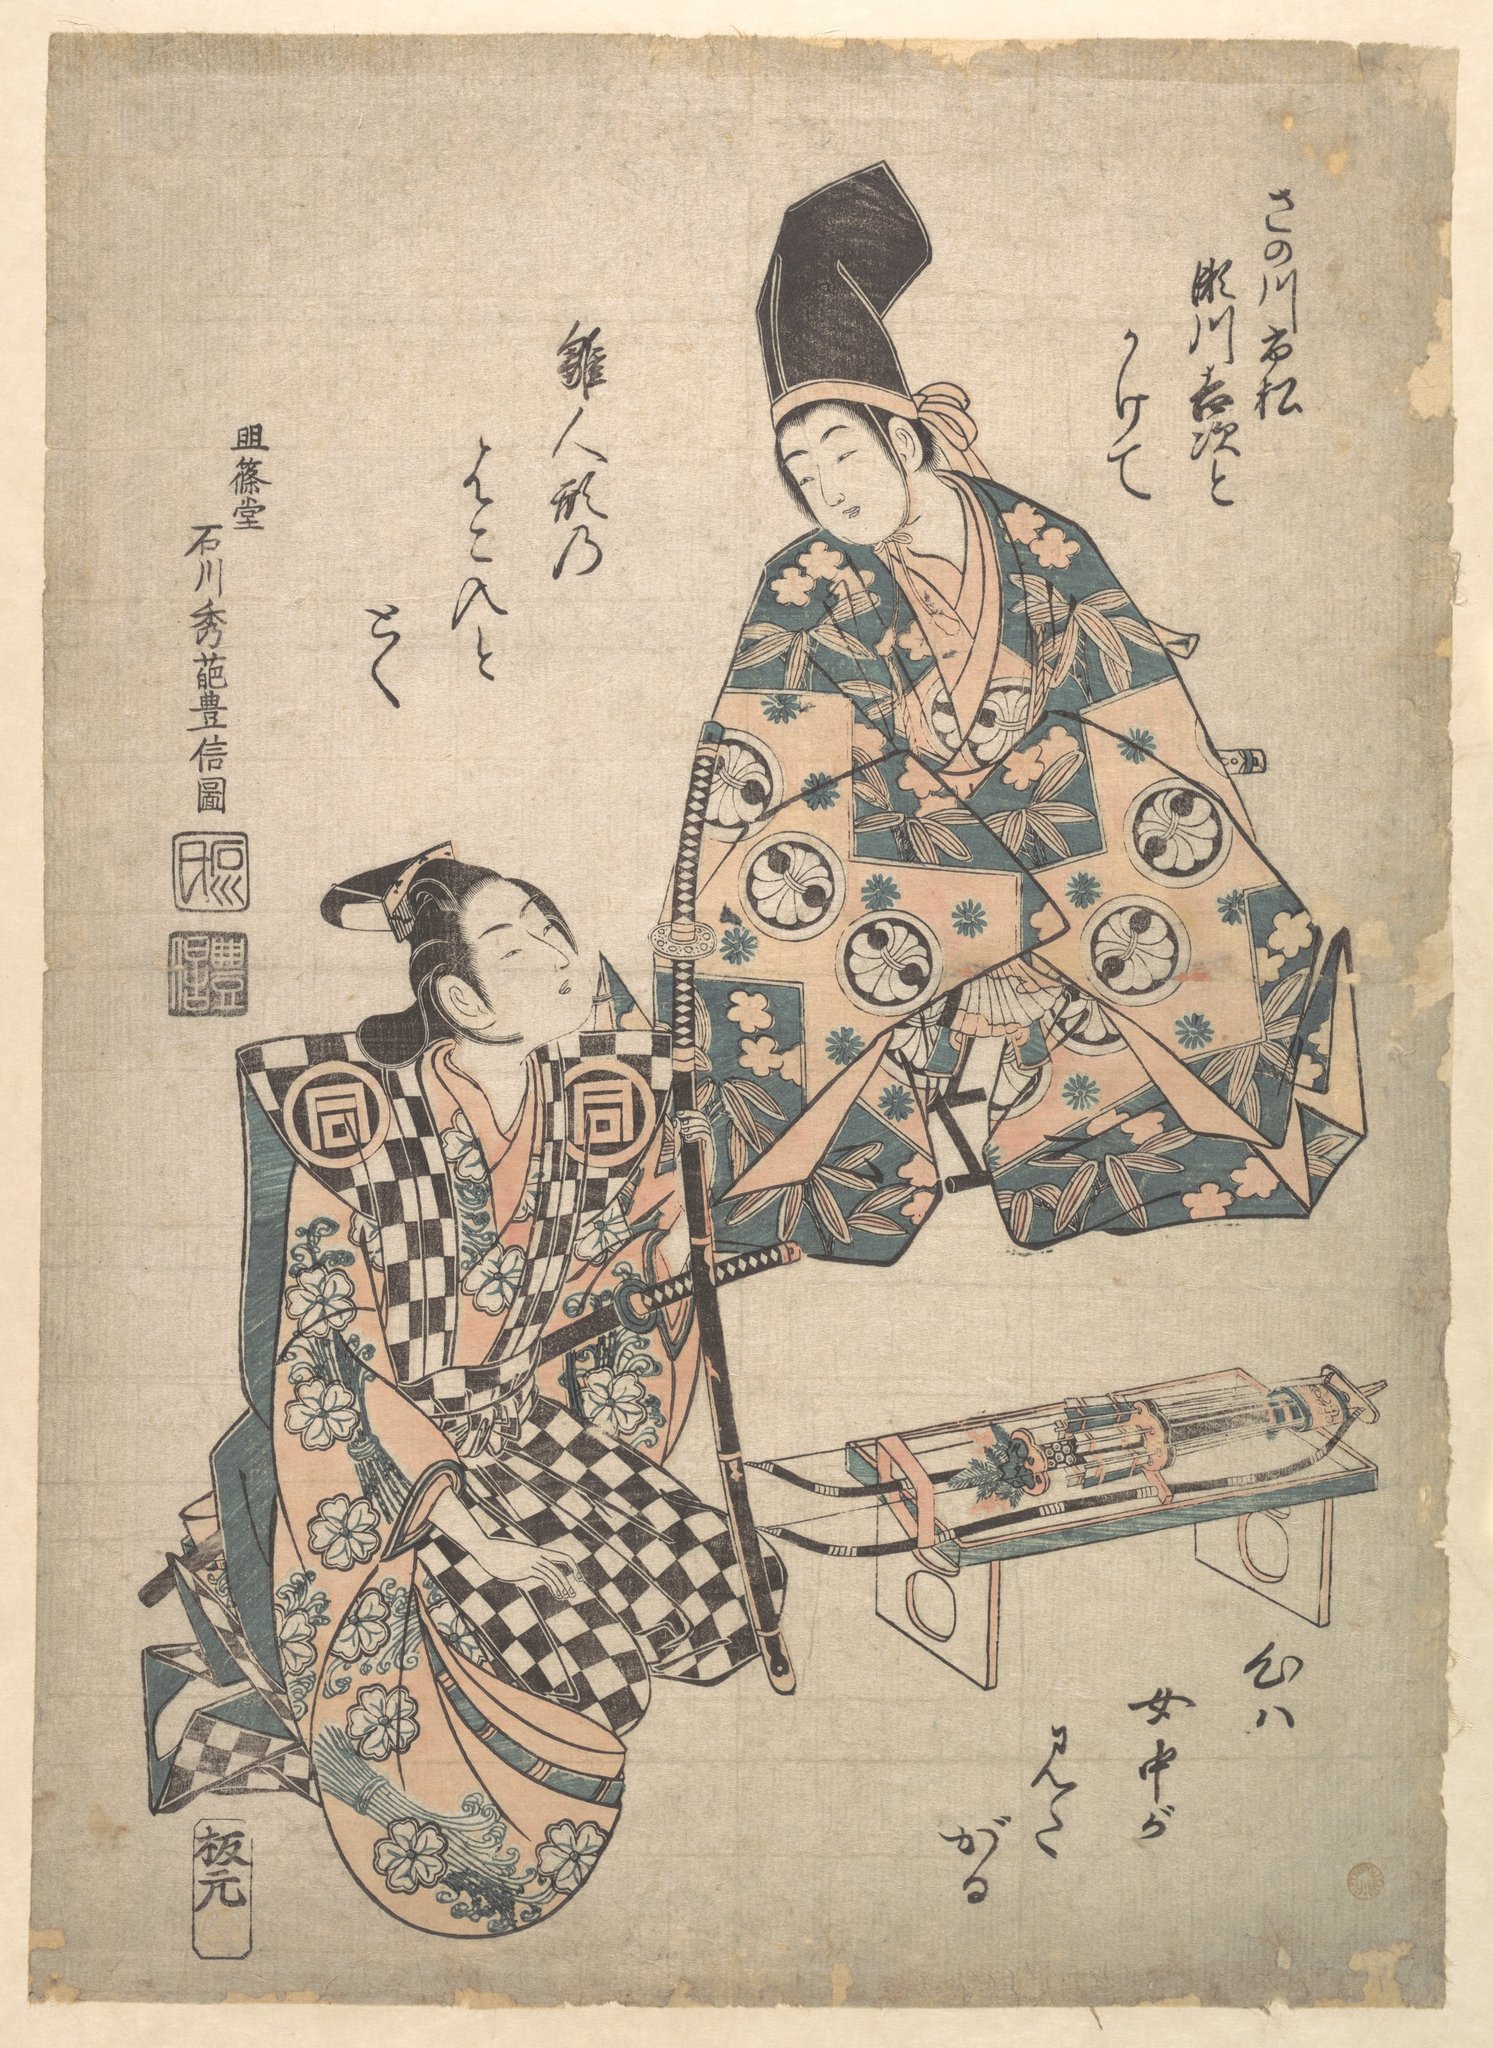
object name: print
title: The Actor Segawa Kichiji as a Daimyo's Young Son, and Sanogawa Ichimatsu as a Samurai Attendant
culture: japanese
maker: ishikawa toyonobu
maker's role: artist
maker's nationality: japanese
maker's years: 1711-1785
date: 1750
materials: ink, paper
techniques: woodblock print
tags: human figures,actors